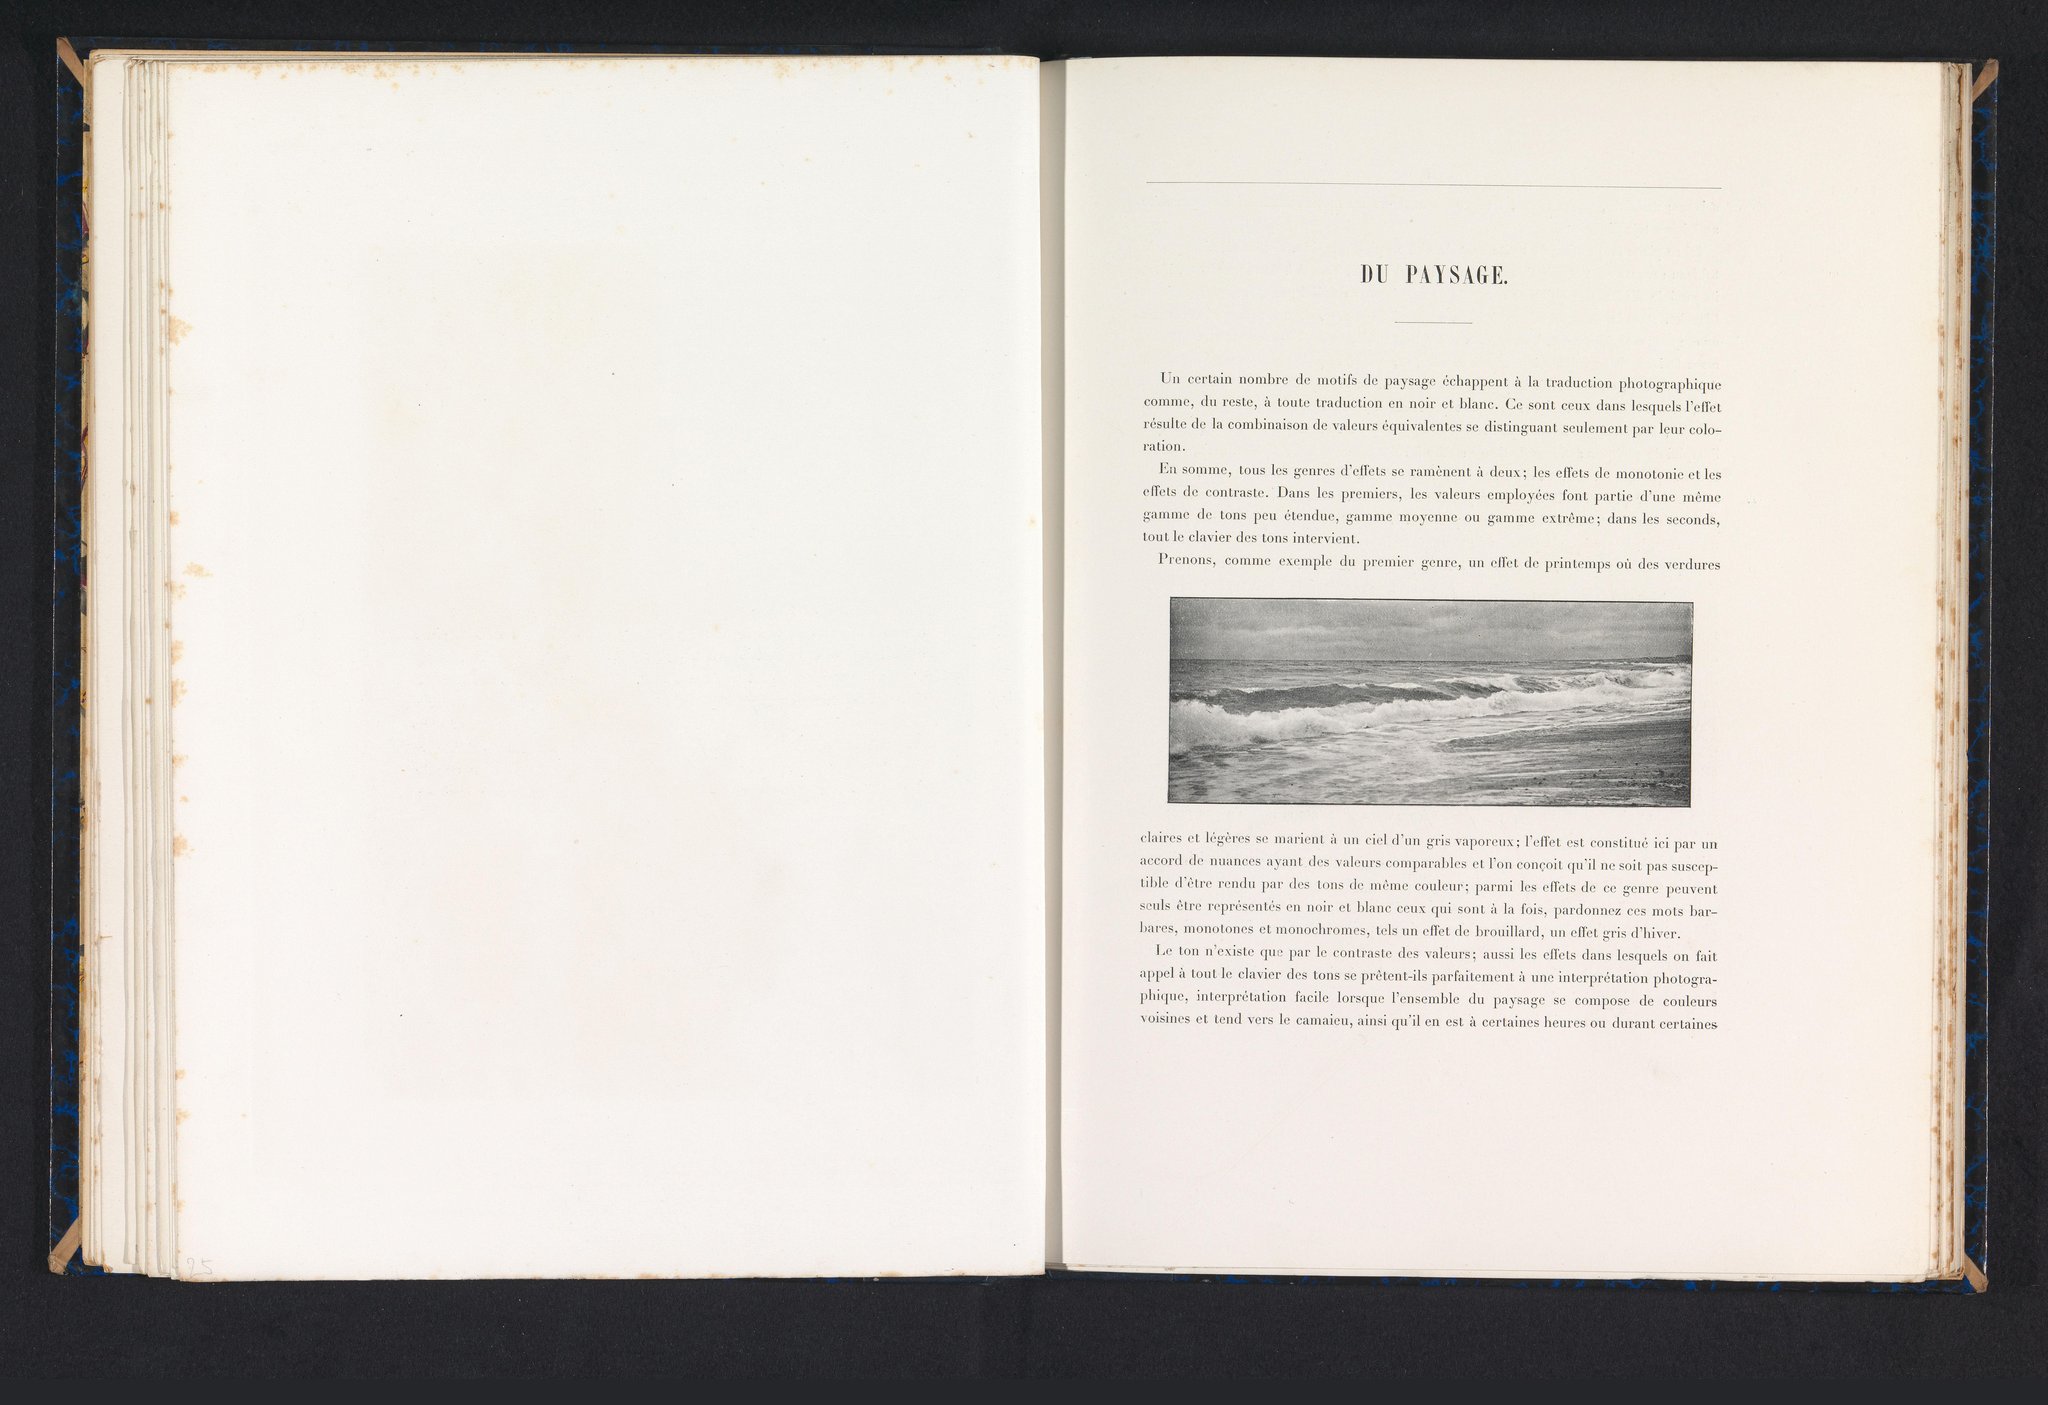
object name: photomechanical print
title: Golven langs een strand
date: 1886-1896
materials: paper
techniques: autotype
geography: france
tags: surf, breakers